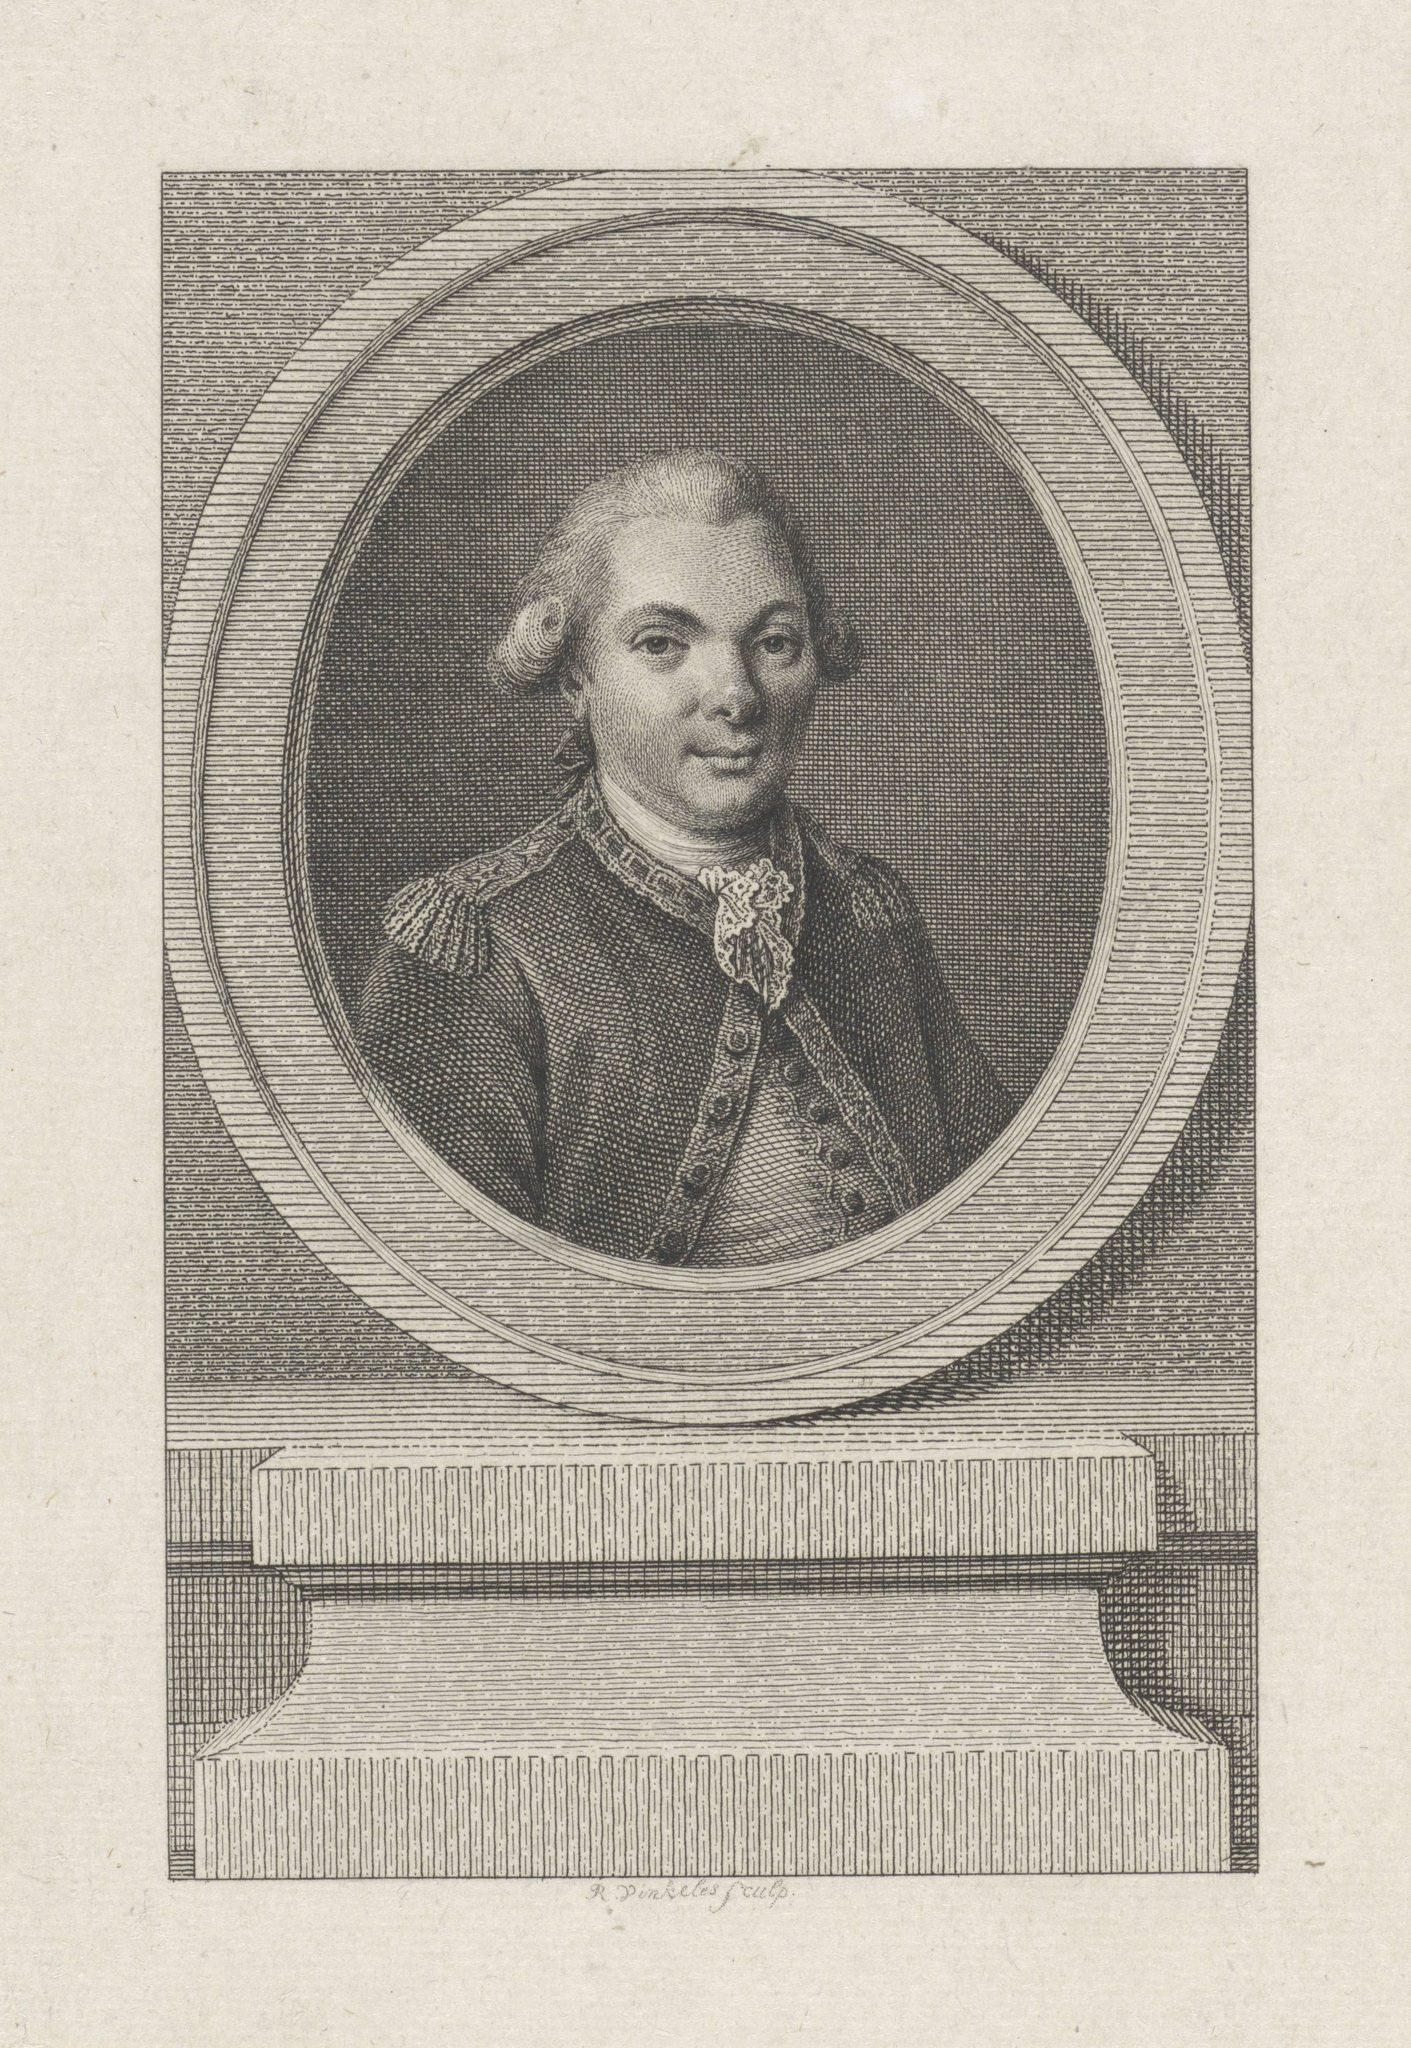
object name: print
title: Portret van Jean-François de La Pérouse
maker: reinier vinkeles (i)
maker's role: draughtsman, print maker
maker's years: 1741-1816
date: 1785-1816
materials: paper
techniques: engraving, etching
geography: amsterdam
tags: albi, officier, ontdekkingsreiziger, jean-françois de la pérouse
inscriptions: collector's mark: Lugt 2228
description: Portret van Jean-François de La Pérouse, Frans marine-officier en ontdekkingsreiziger.